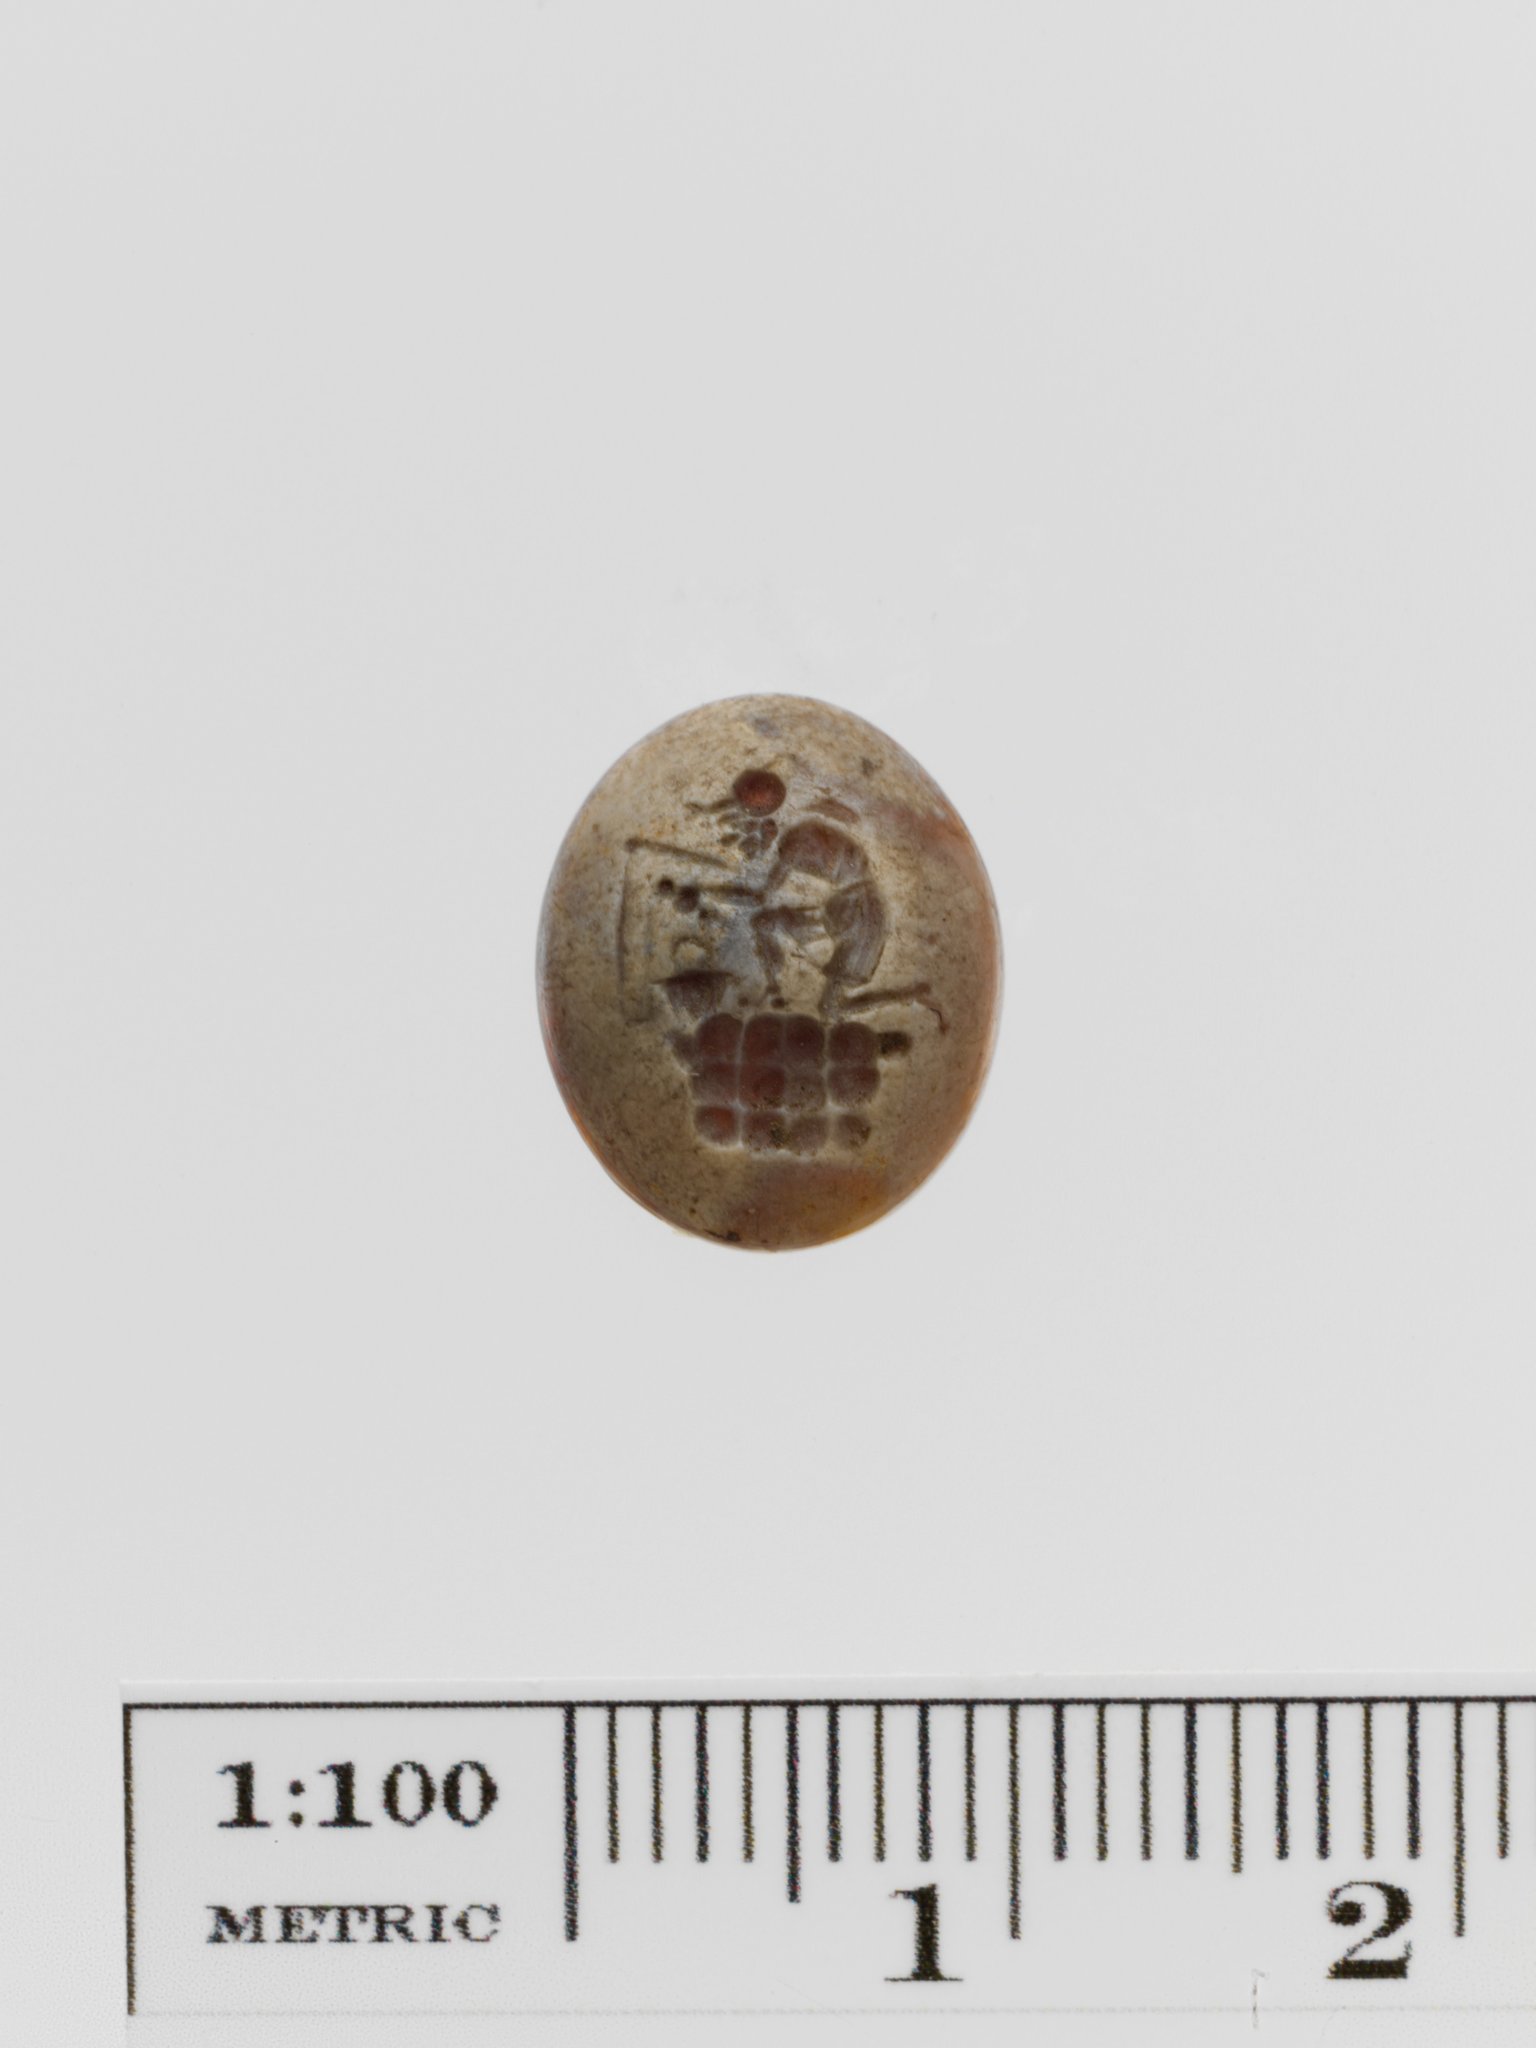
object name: intaglio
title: Agate ring stone intaglio: fisherman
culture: italic or roman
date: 200-201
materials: stone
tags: men,fishing